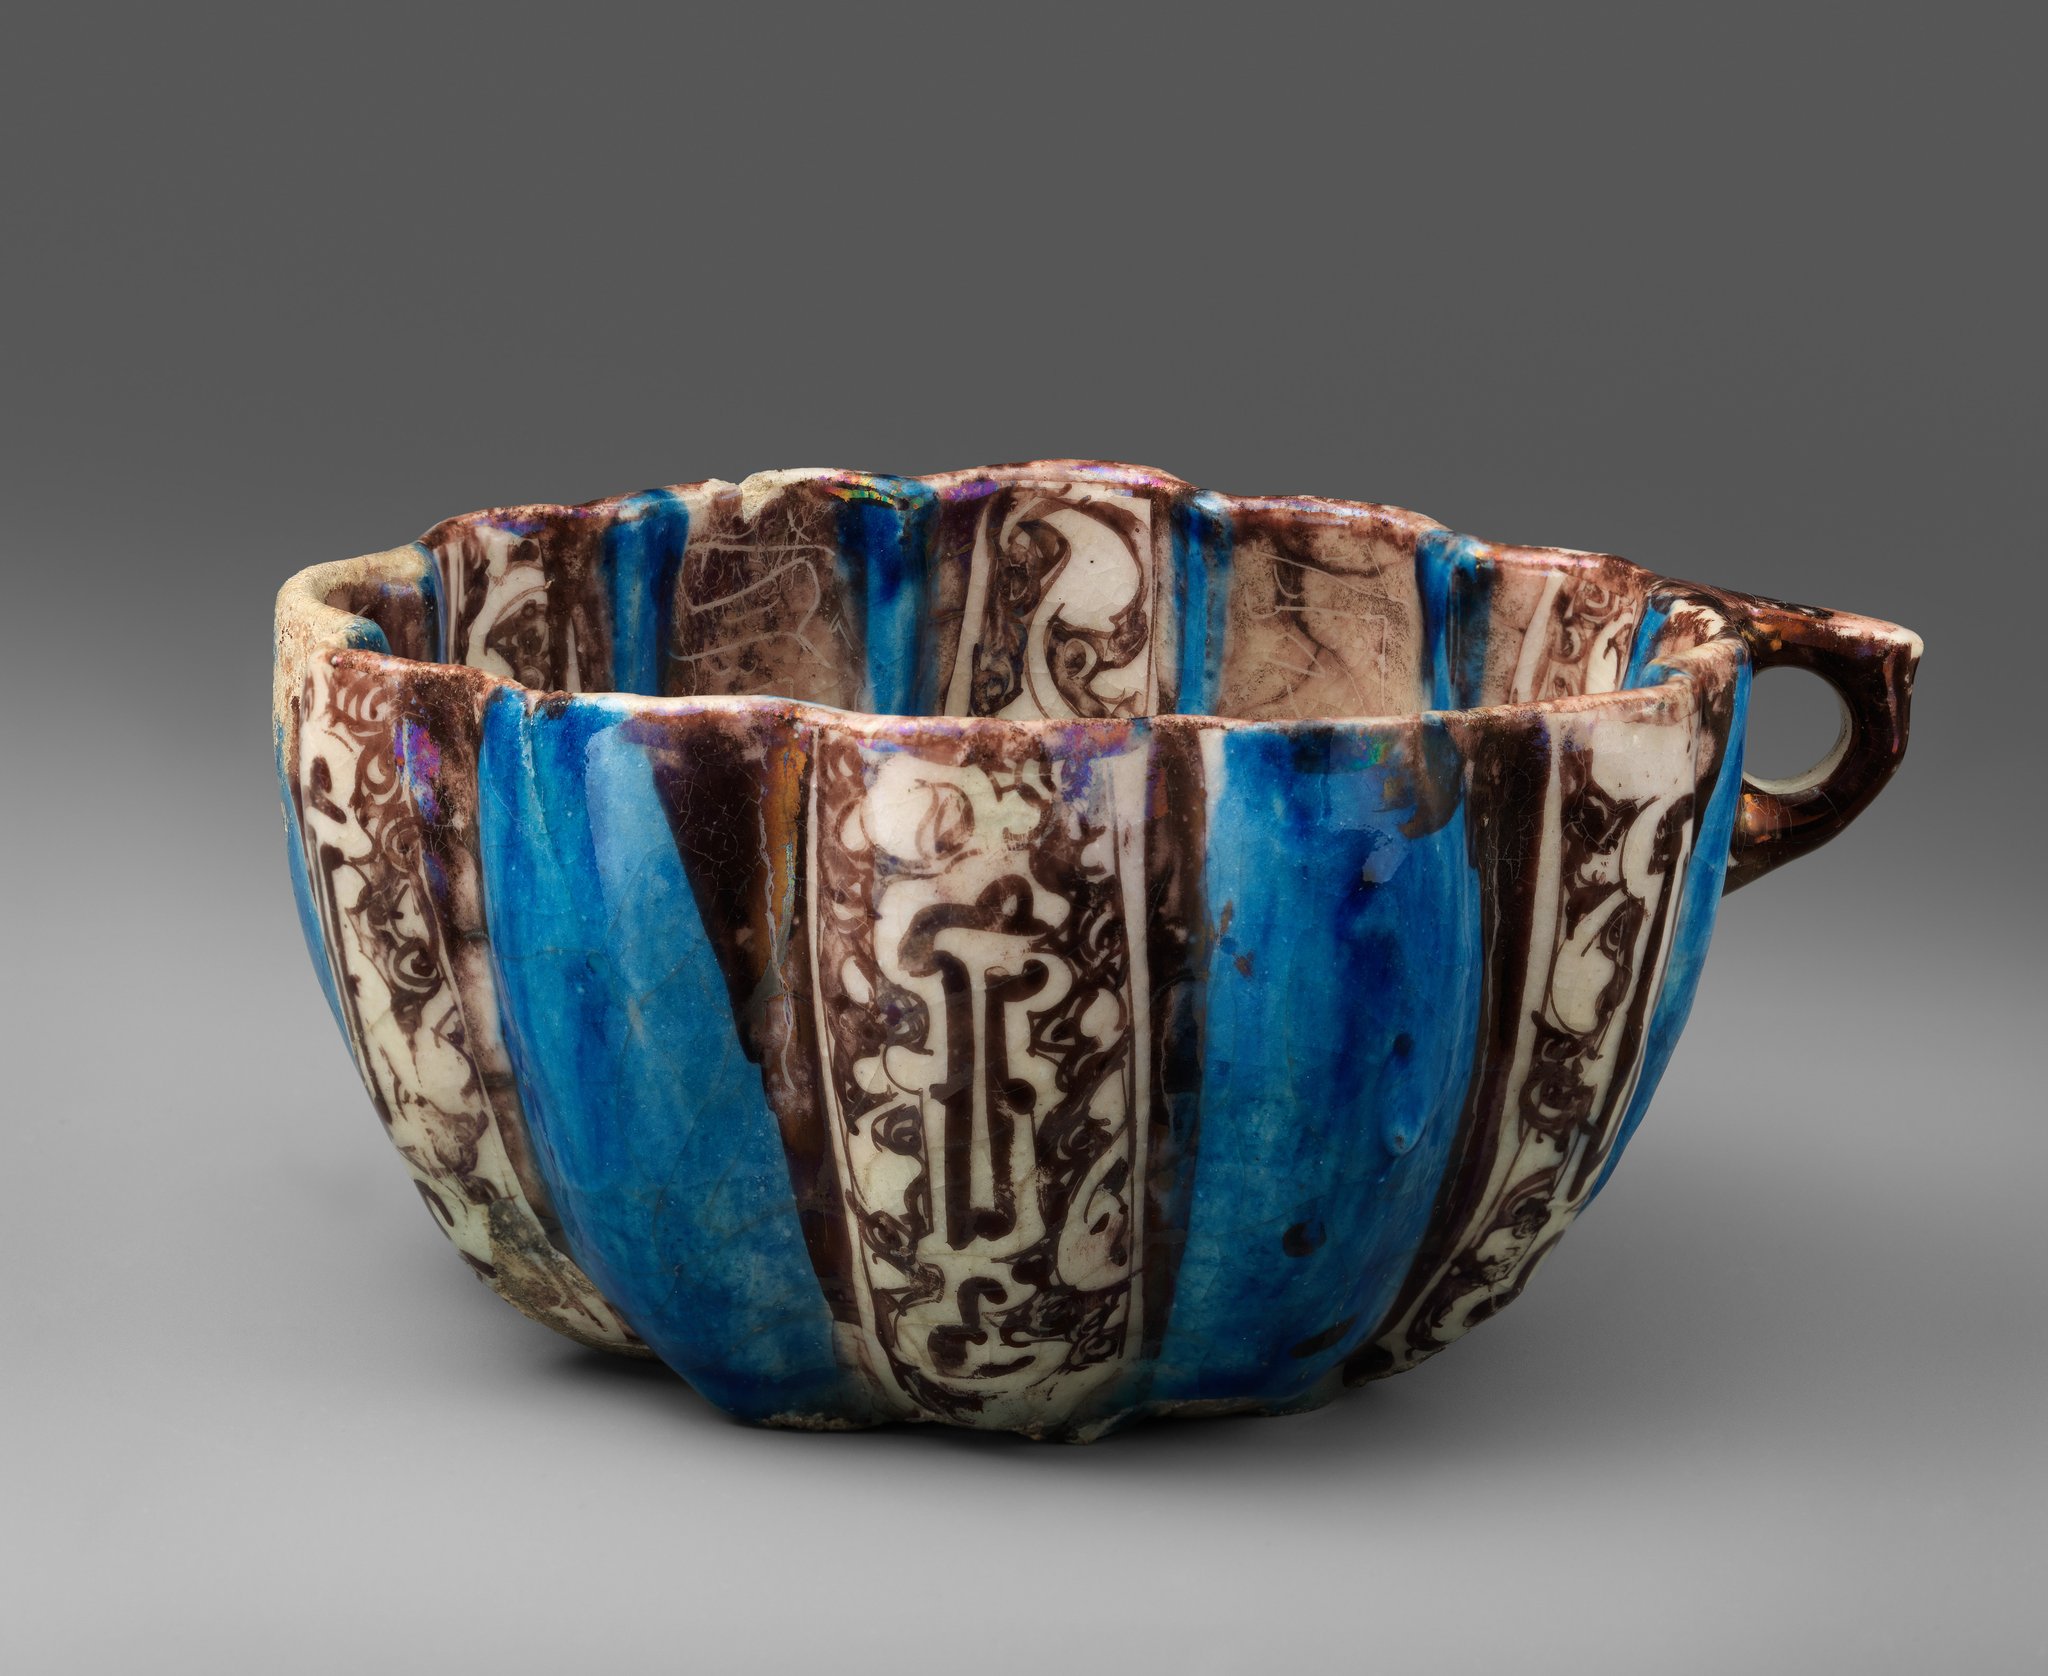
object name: bowl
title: Lobed Bowl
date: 1151-1200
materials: glaze, stonepaste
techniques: glazing, luster painting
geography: syria